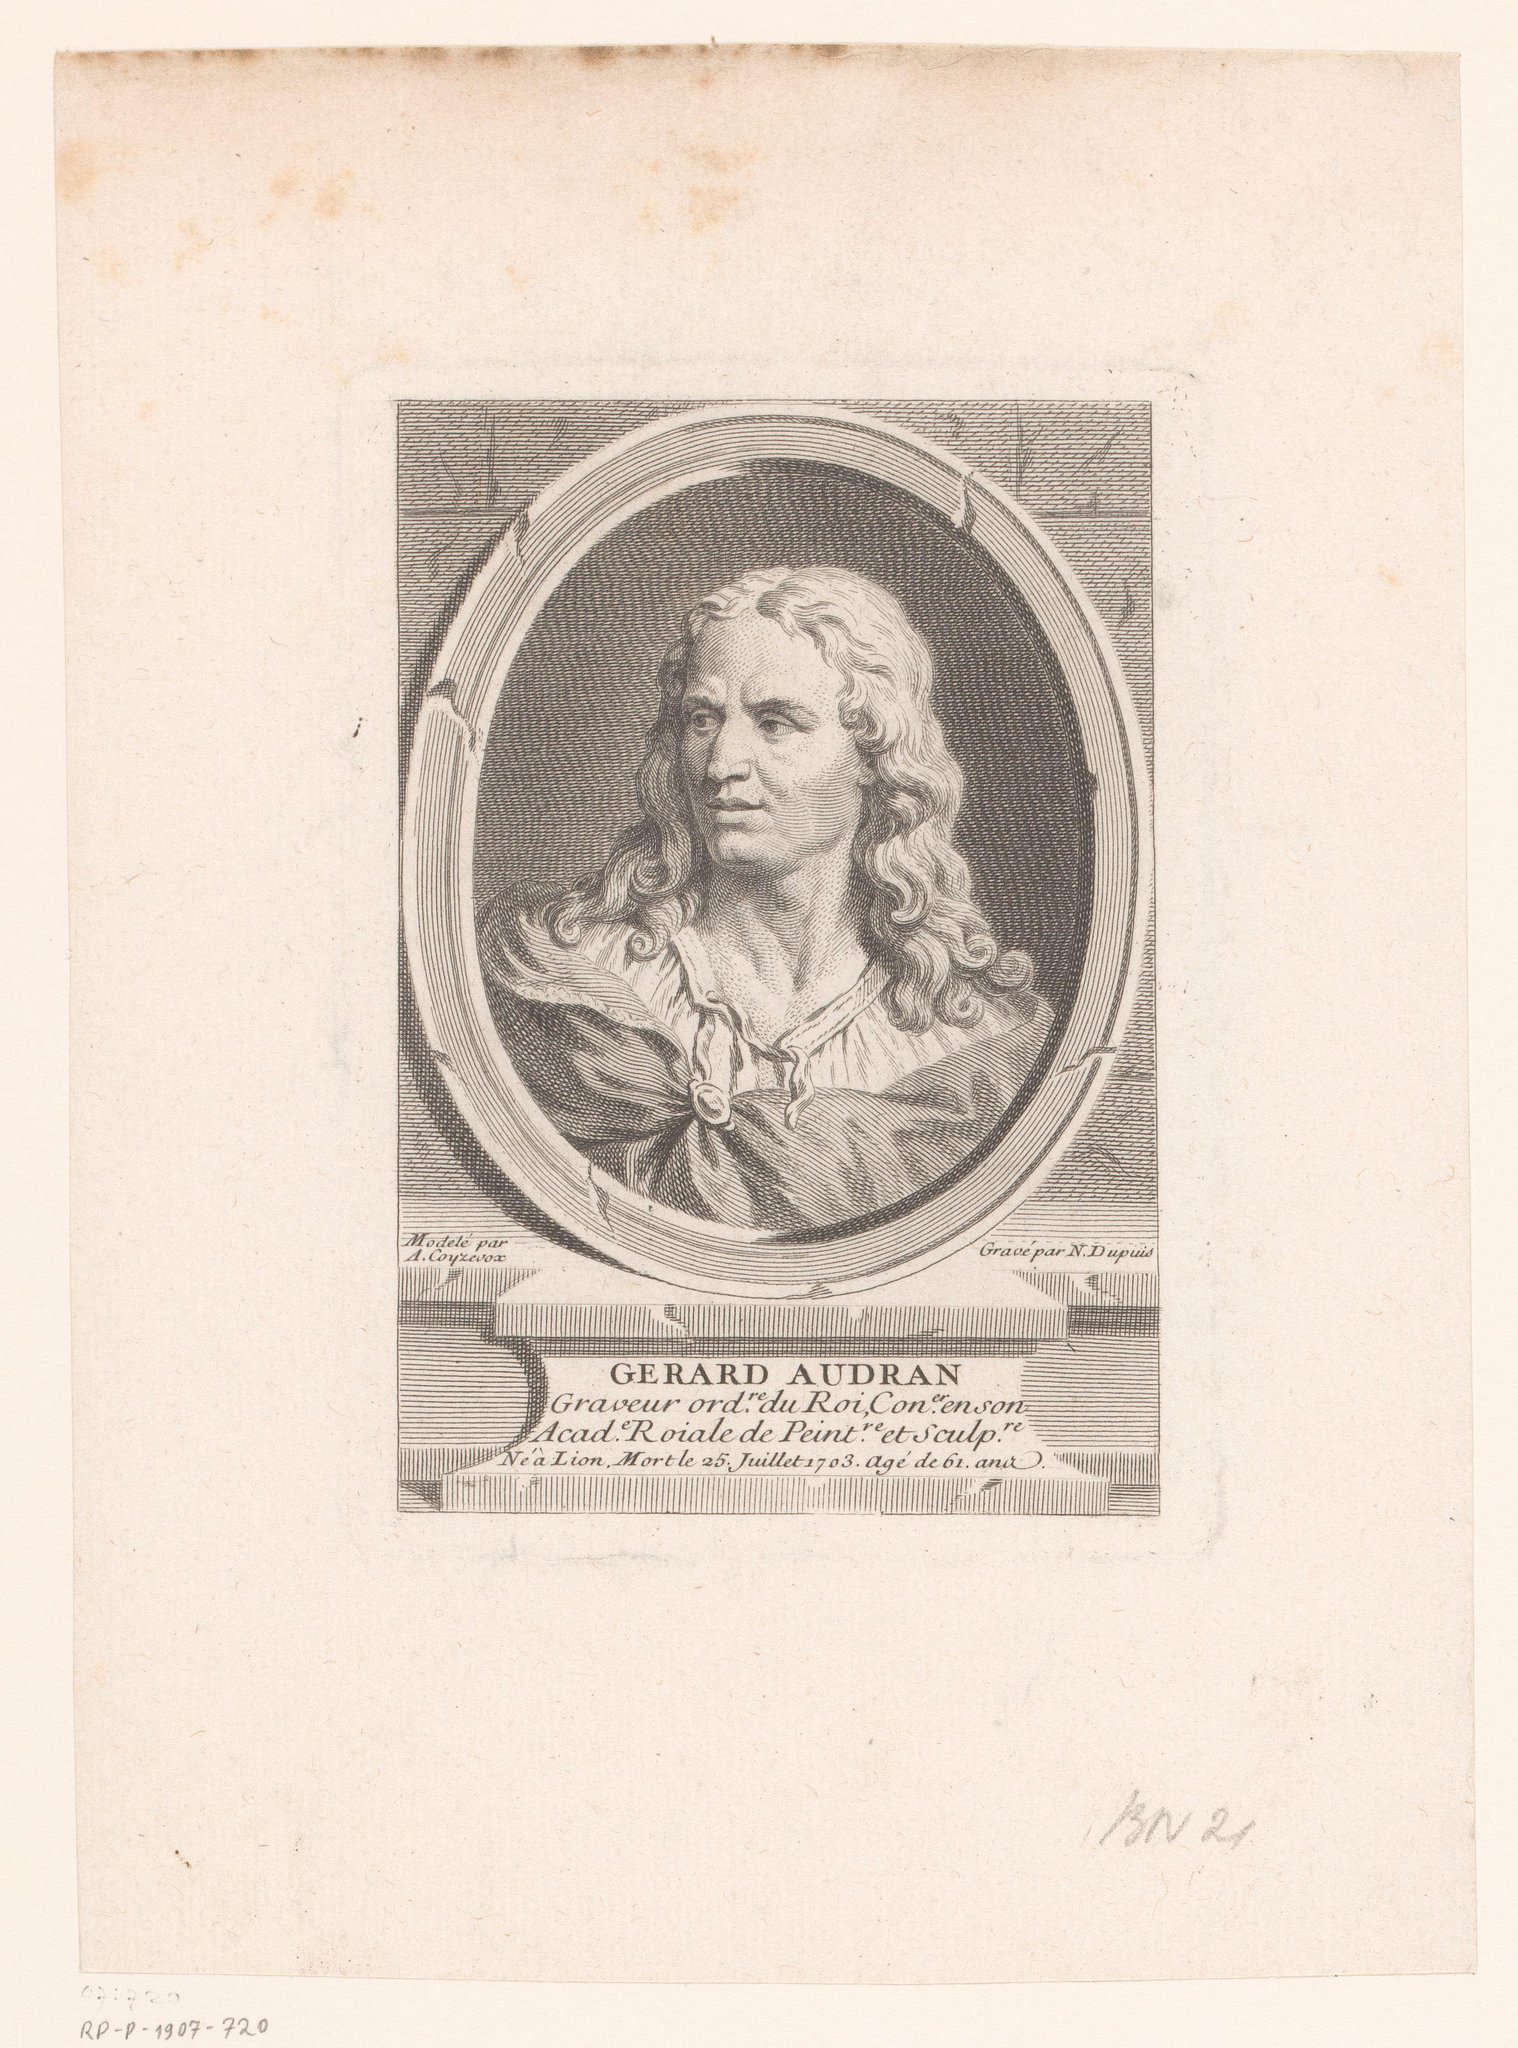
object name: print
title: Gerard Audran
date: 1738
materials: paper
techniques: engraving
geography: france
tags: print maker, gérard audran, ornament ~ medallion, portrait, self-portrait of graphic artist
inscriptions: collector's mark: Lugt 2228